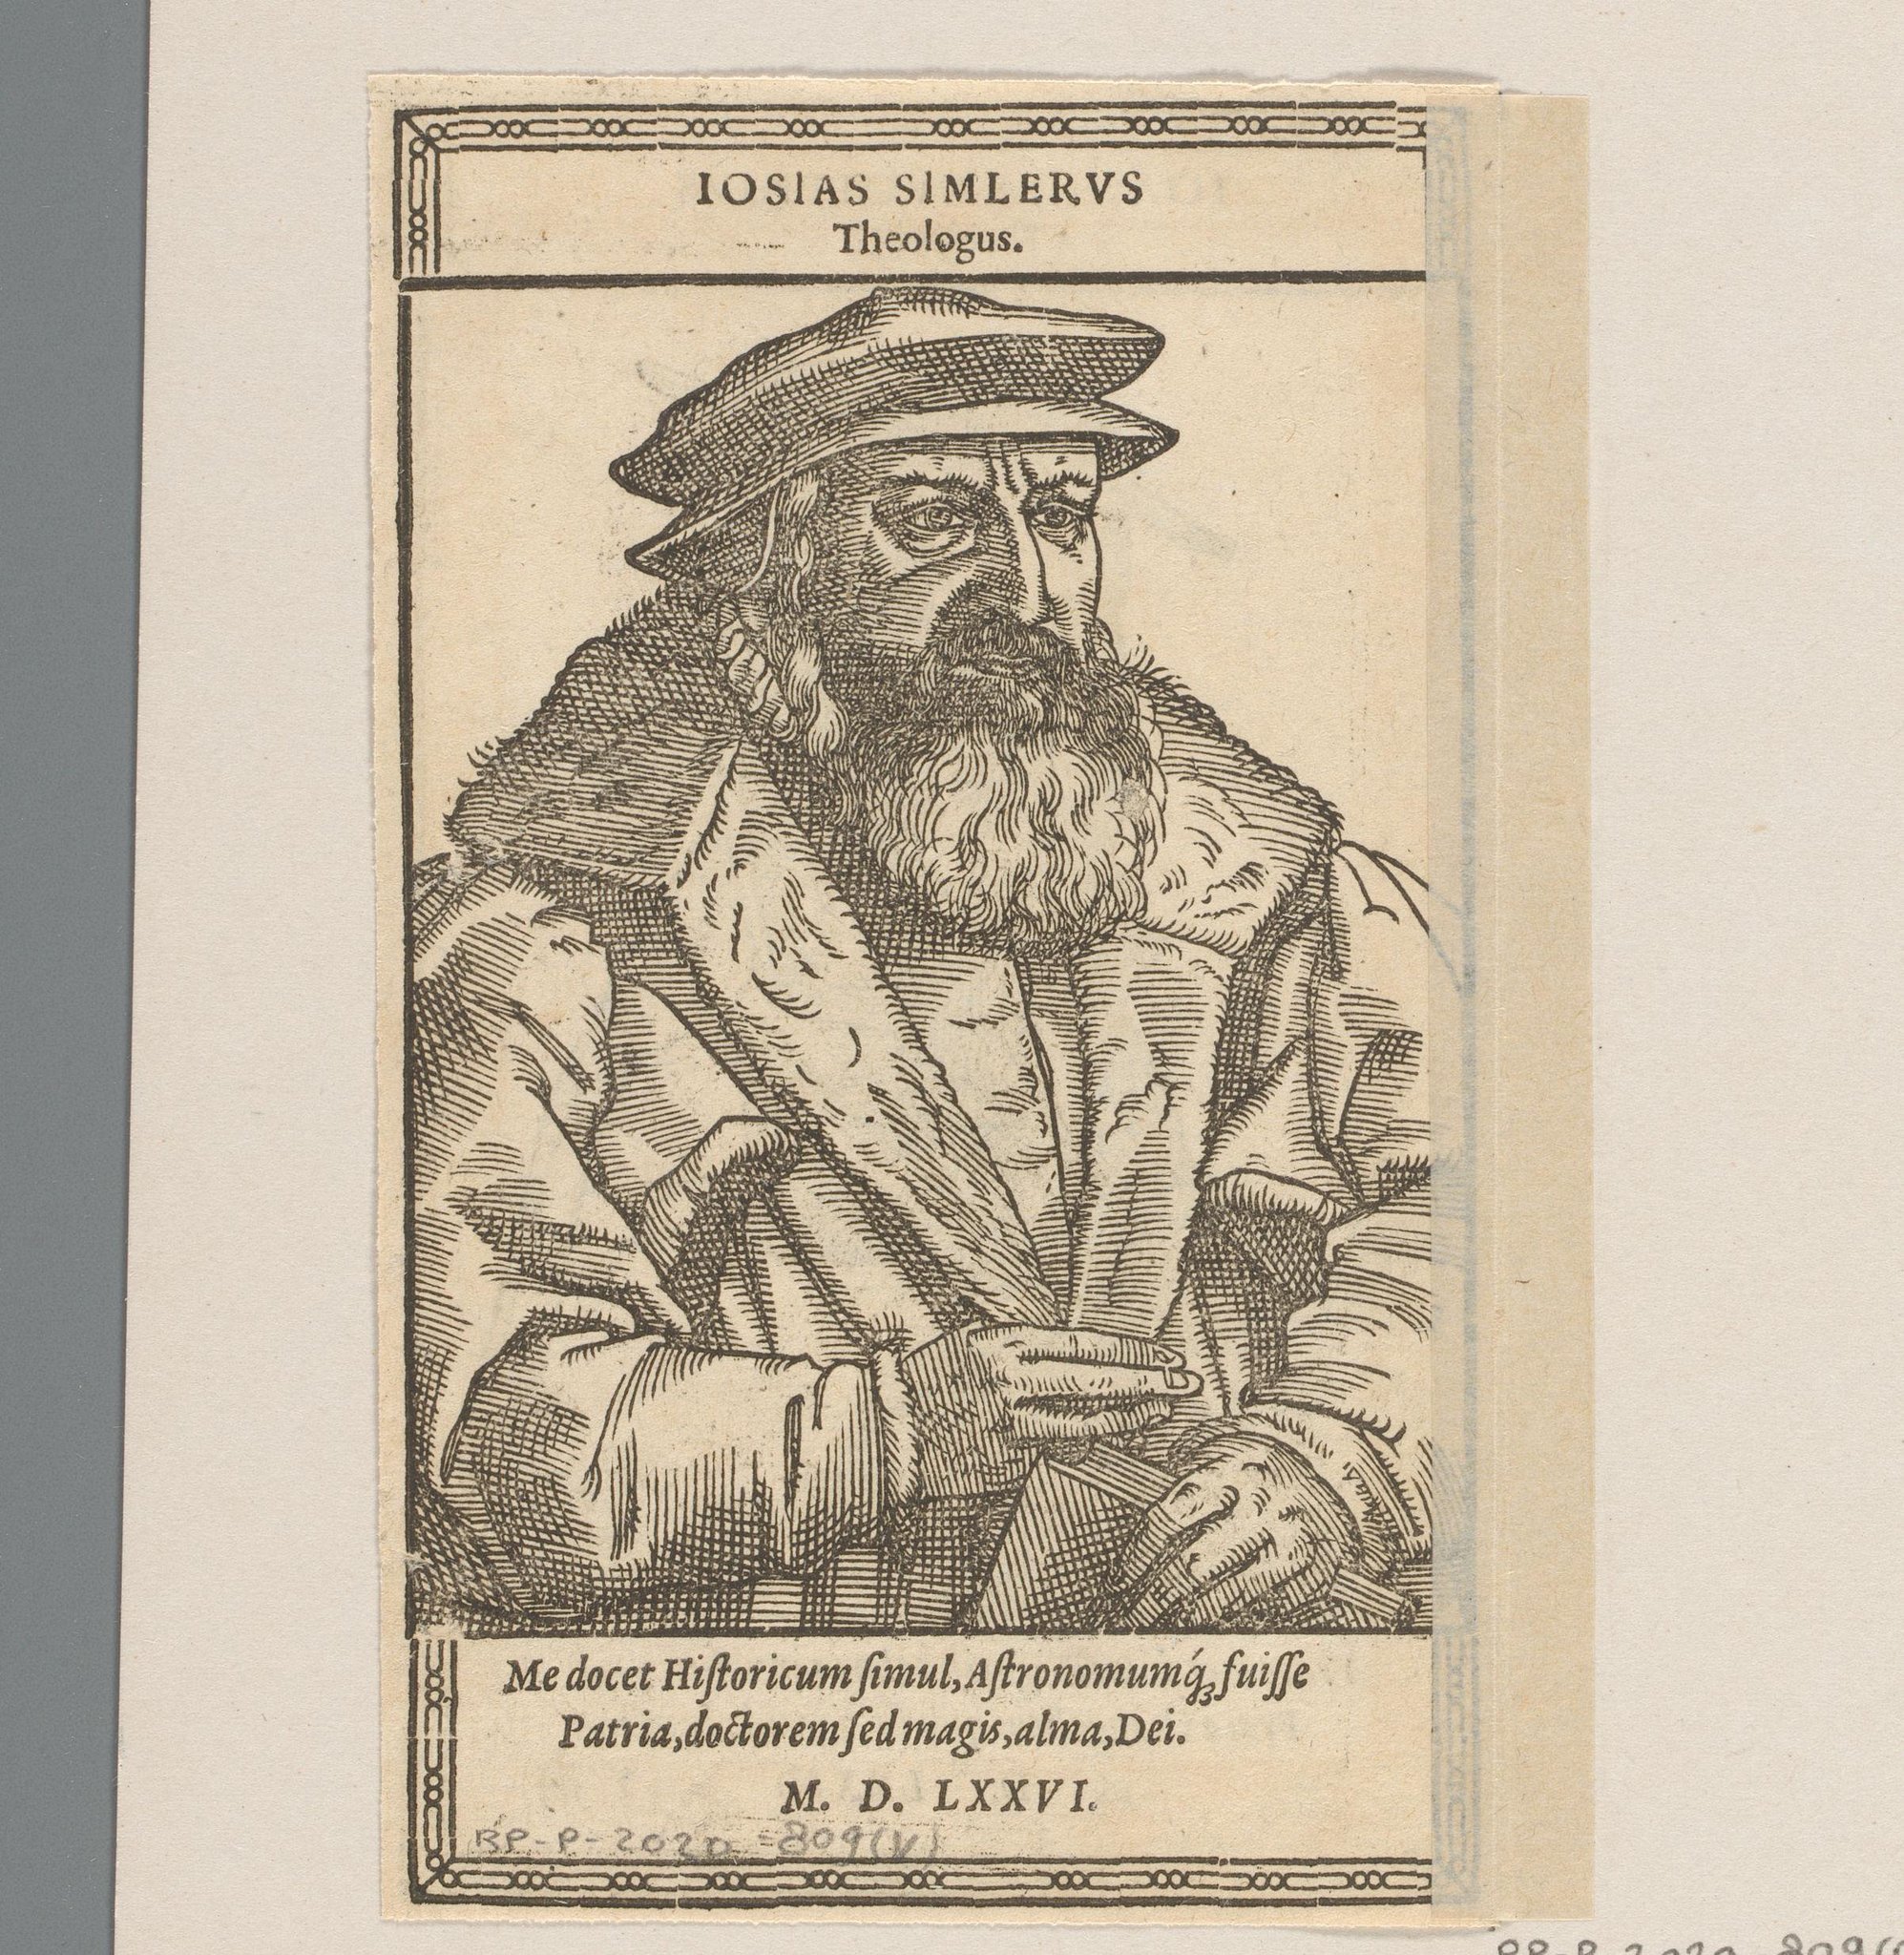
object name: book illustration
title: Portret van Josias Simmler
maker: bernhard jobin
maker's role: printer, publisher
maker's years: 1545-1593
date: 1587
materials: paper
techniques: letterpress printing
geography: straatsburg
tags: theologian, historical persons, book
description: Prent uit: Reusner, Nikolaus. Icones sive imagines virorum literis illustrium (...). Straatsburg: Bernhard Jobin, 1587. Prent ook gebruikt in de Duitse editie, uitgegeven in hetzelfde jaar, en de 1590-editie. Prent ook gebruikt in latere publicaties.